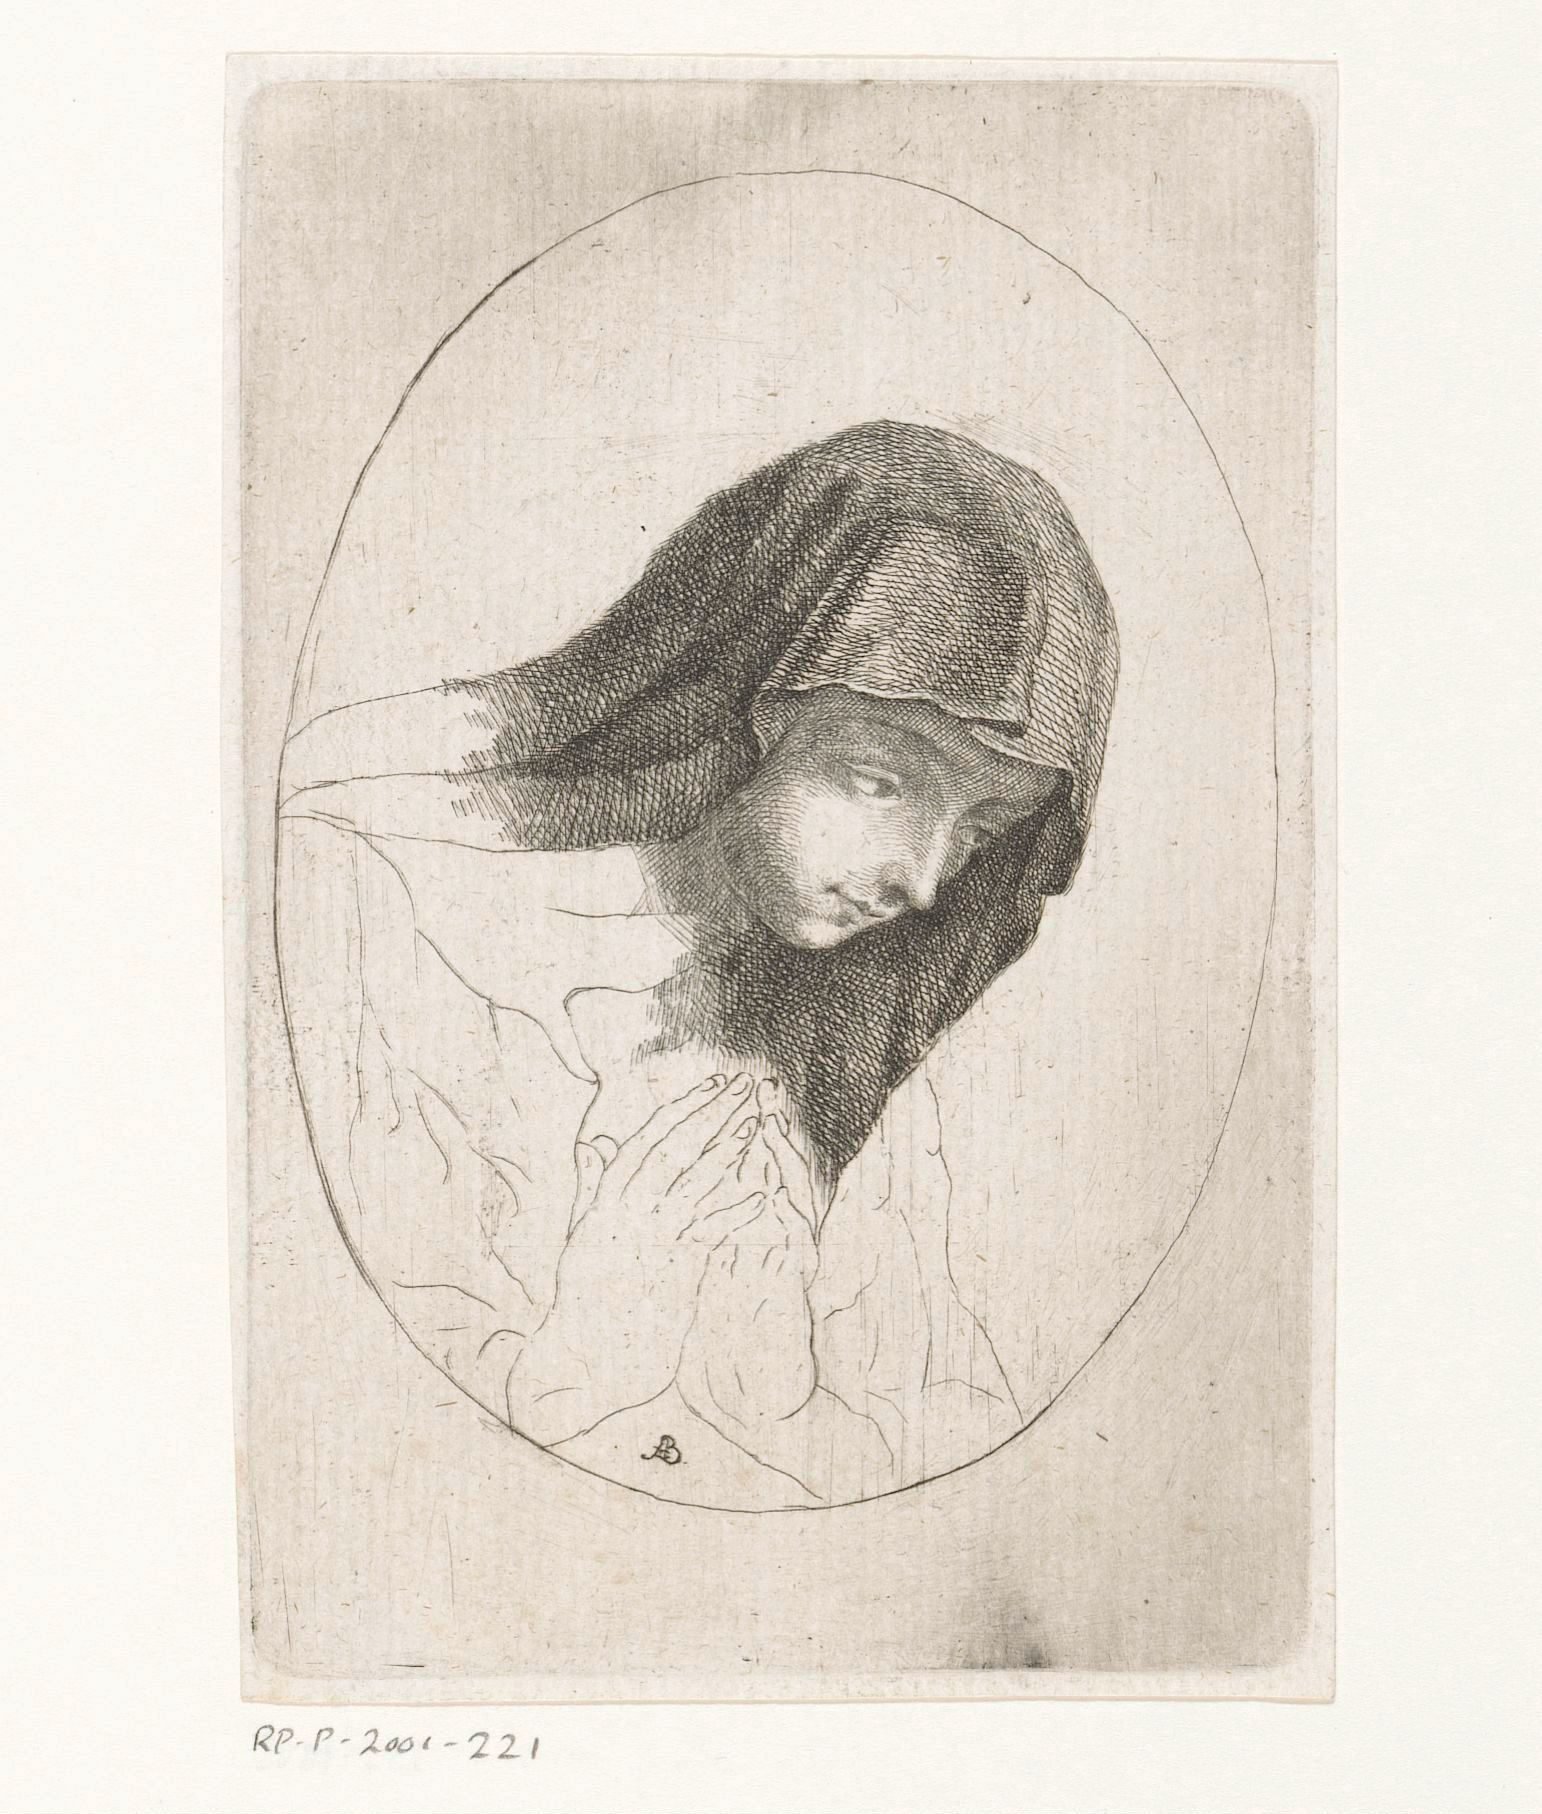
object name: print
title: Biddende vrouw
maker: amalie baader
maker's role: print maker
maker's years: 1763-1840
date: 1773-1840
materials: paper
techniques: etching, intaglio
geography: germany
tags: one person praying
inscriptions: collector's mark: Lugt 2760, collector's mark: Lugt 2228